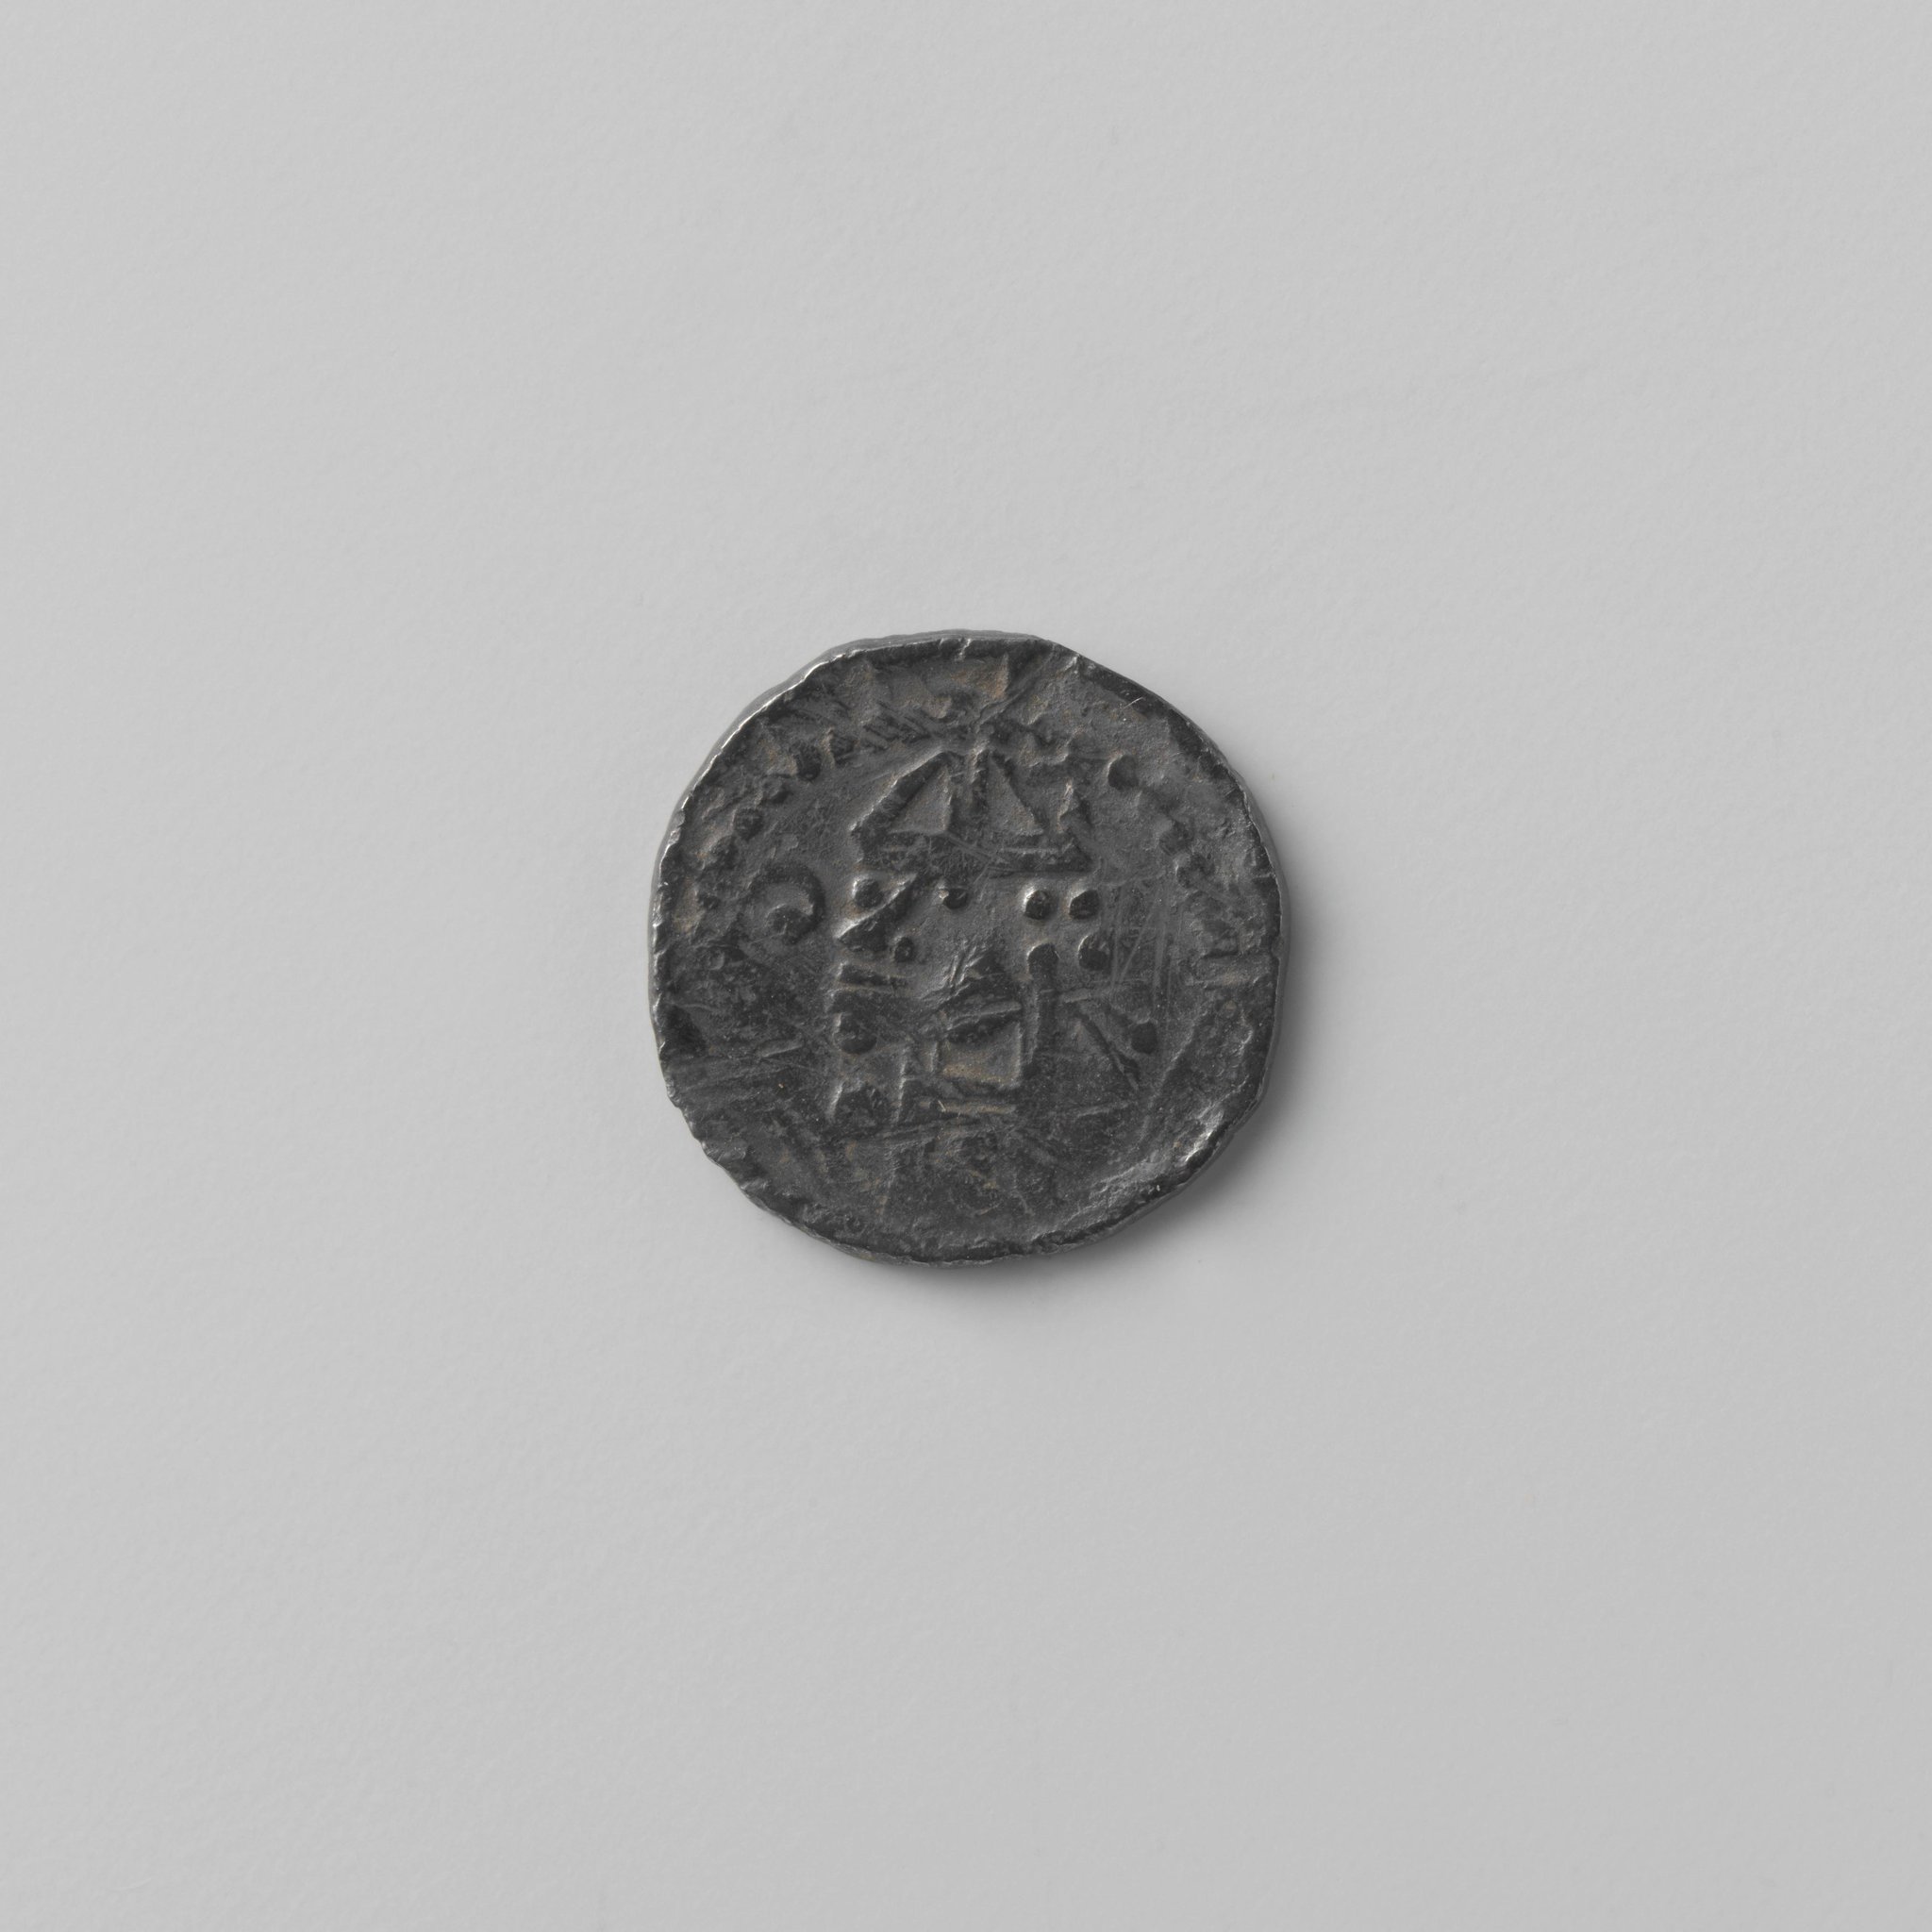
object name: coin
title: Utrechtse penning van Hendrik van Vianden, 1250-1267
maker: hendrik i van vianden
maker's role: bisschop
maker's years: -1267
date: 1250-1267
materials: silver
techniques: striking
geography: utrecht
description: Zilveren munt. Voorzijde: portret van de bisschop van voren met mijter met in rechterhand bisschopsstaf, in linkerhand boek. Keerzijde: kort versierd kruis.